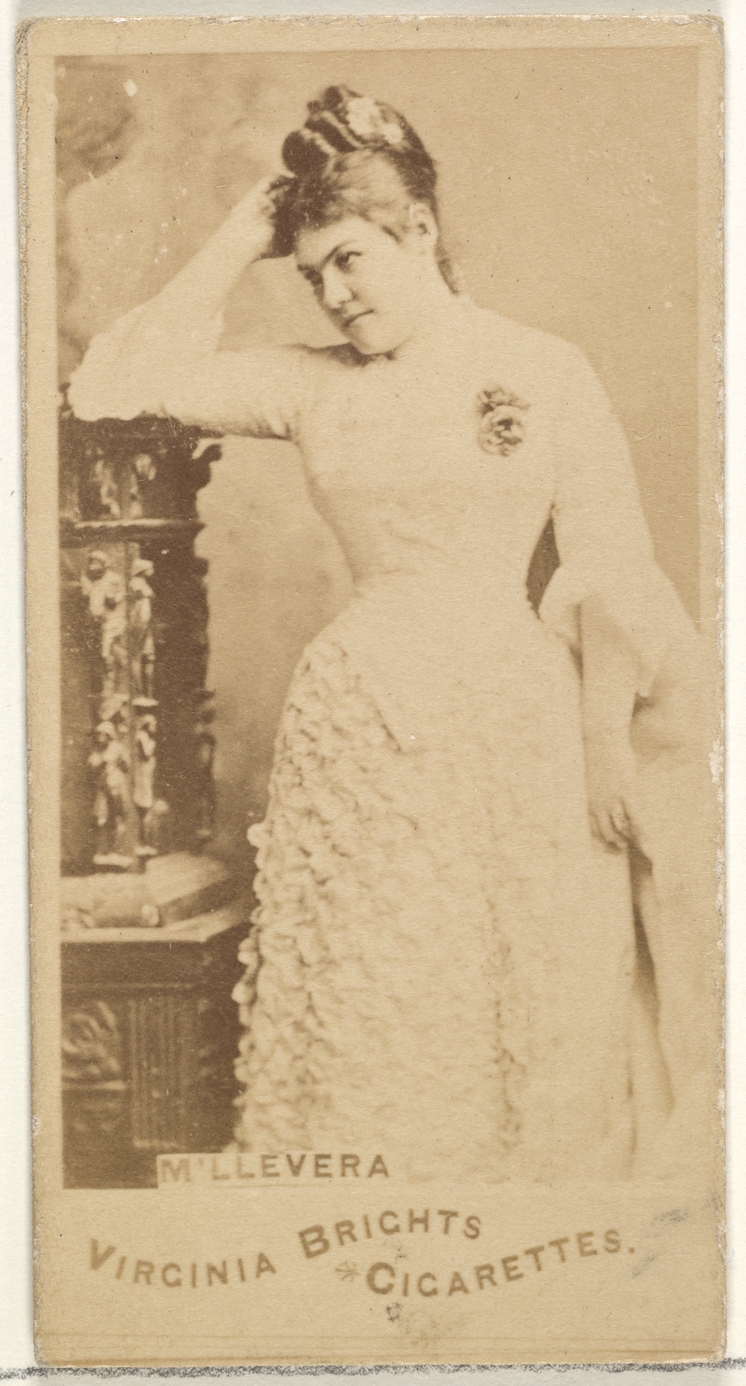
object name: photograph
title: M'lle Vera, from the Actors and Actresses series (N45, Type 1) for Virginia Brights Cigarettes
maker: allen & ginter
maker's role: publisher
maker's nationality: american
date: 1888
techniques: albumen silver print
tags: portraits,women,actresses